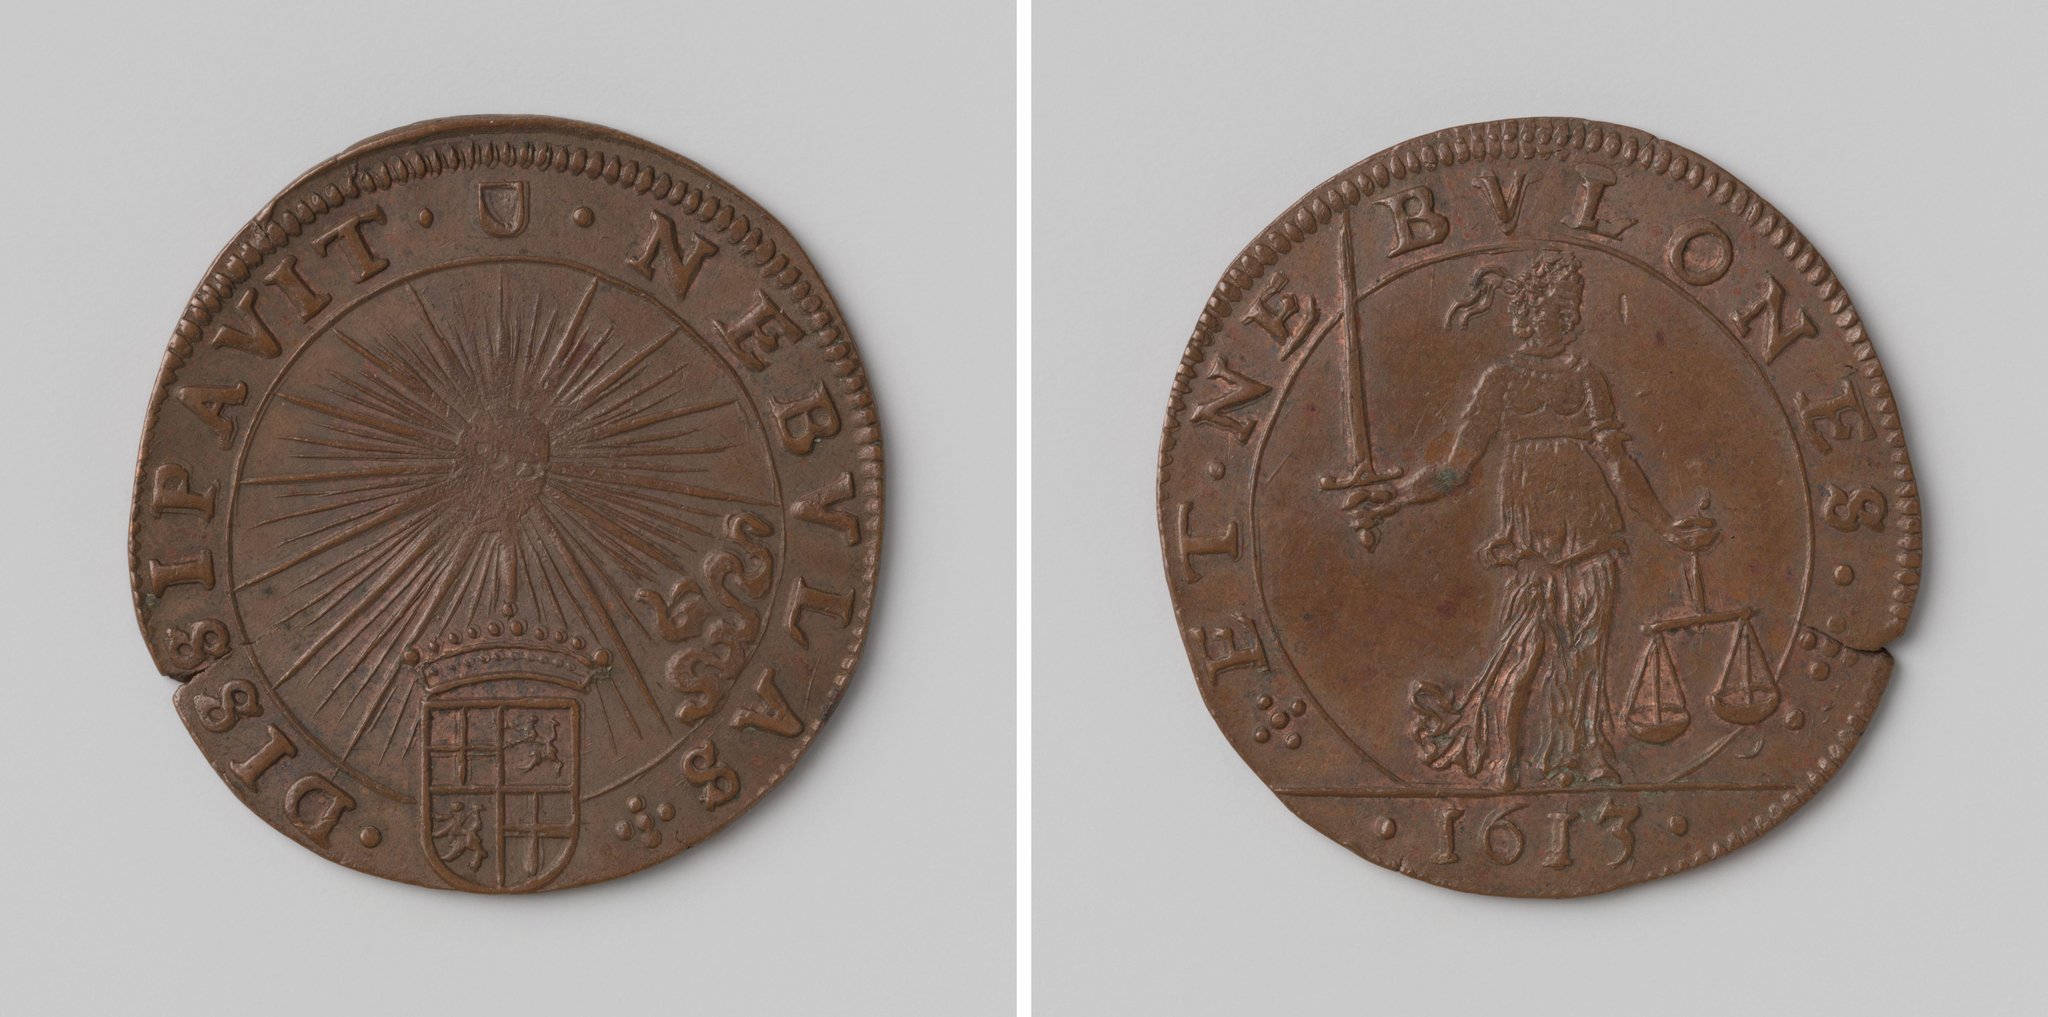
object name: jeton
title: Stillen van het oproer te Utrecht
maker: Anonymous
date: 1613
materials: copper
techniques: striking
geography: utrecht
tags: staten van zeeland, eemland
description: Koperen penning. Voorzijde: stralende zon verdrijft nevel boven gekroond wapenschild binnen omschrift. Keerzijde: Gerechtigheid met zwaard en weegschaal in handen binnen omschrift; afsnede: jaartal